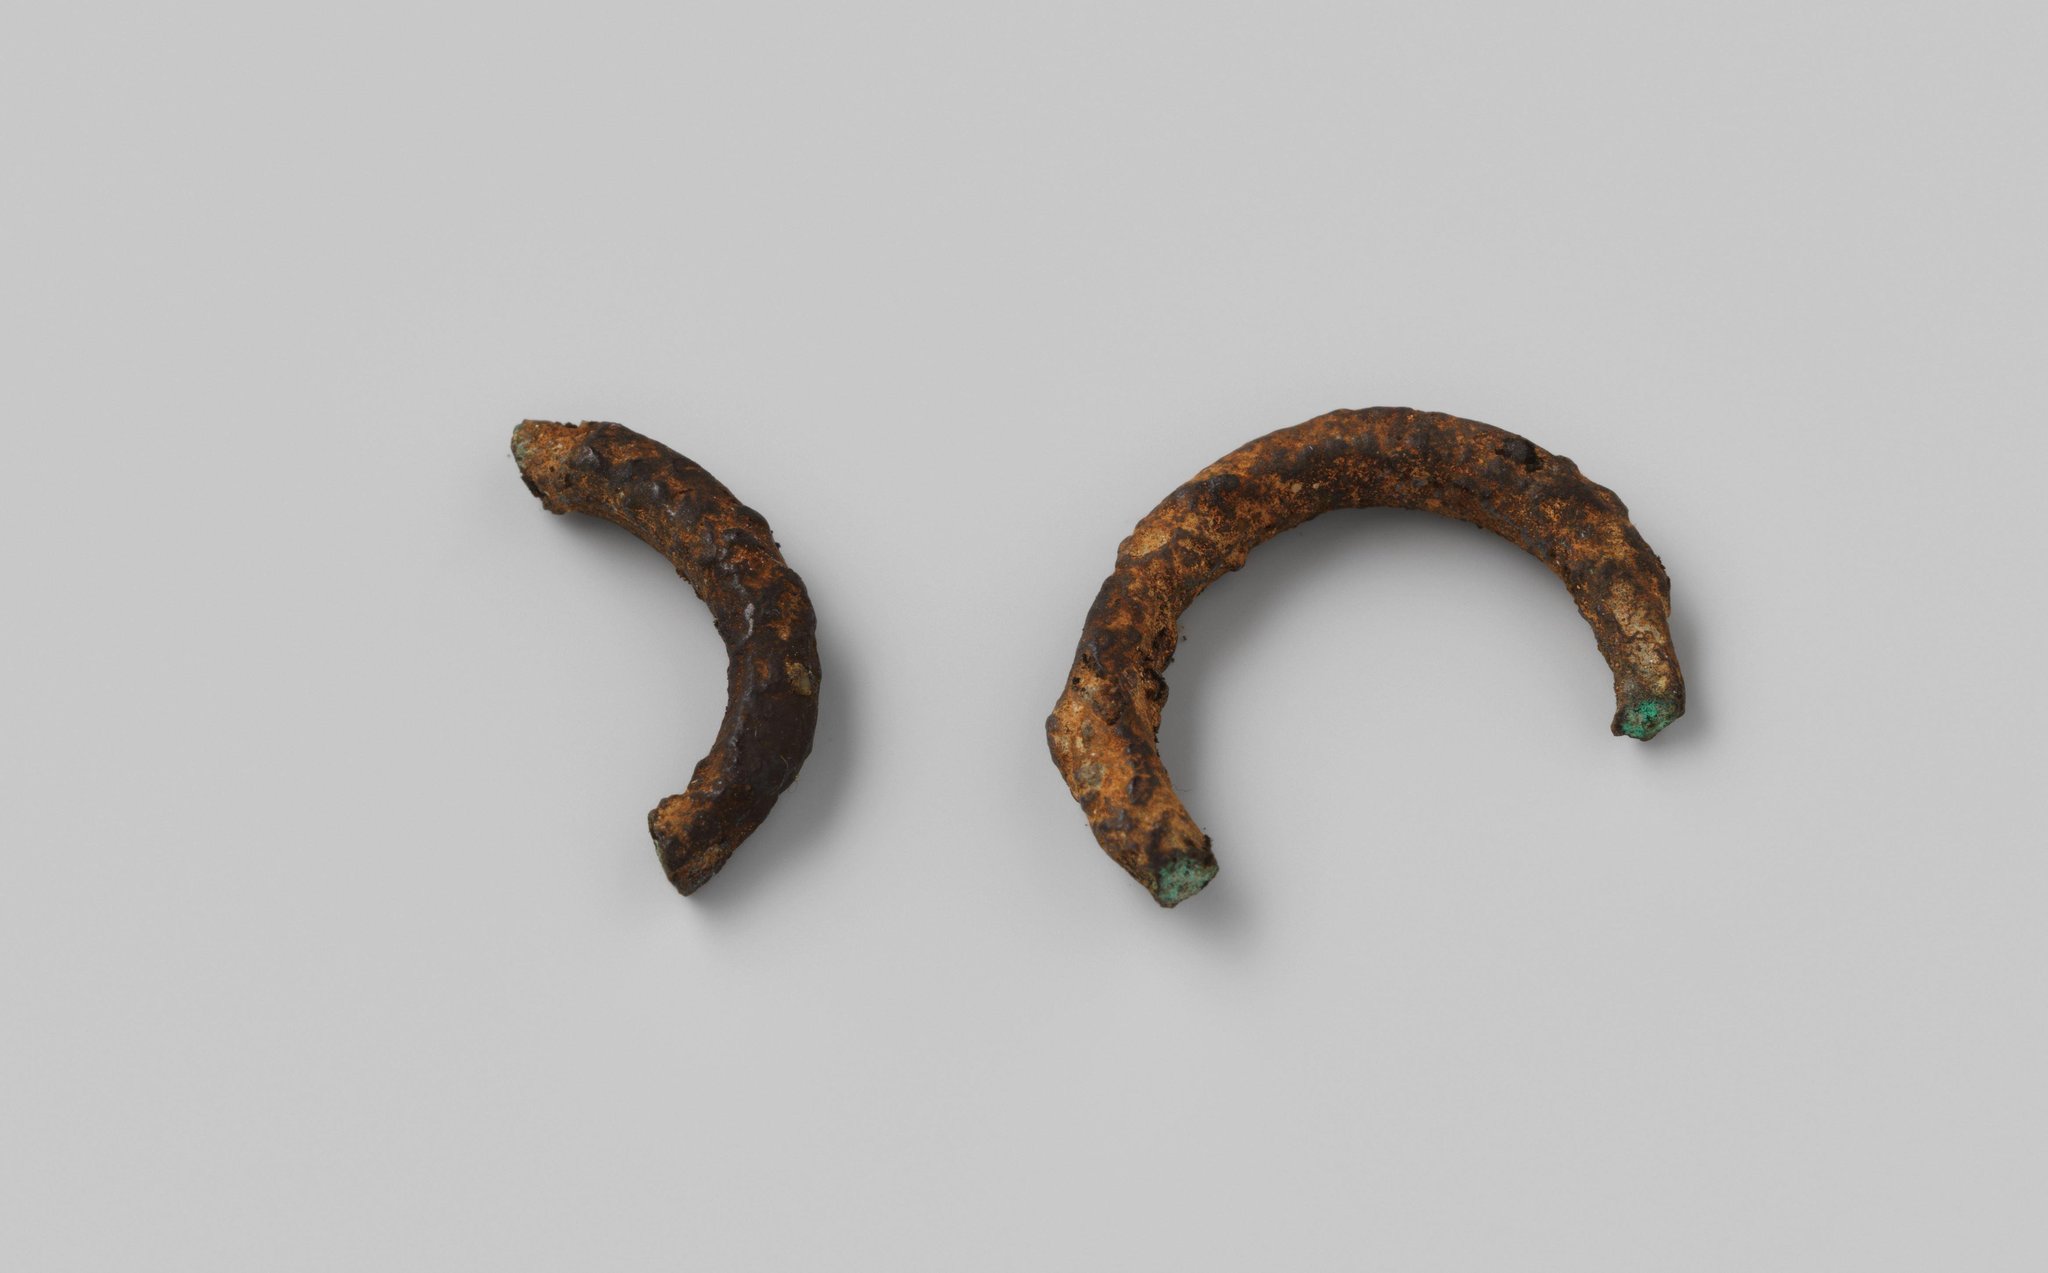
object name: fragment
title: Gebroken ringvormig fragment uit het wrak van de Oost-Indiëvaarder Hollandia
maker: Anonymous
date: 1700-1743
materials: copper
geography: netherlands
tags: verenigde oostindische compagnie, hollandia (schip), annet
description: Varied parts or fragments, rings or ring-shaped fragments; fragm, id. 80H625.